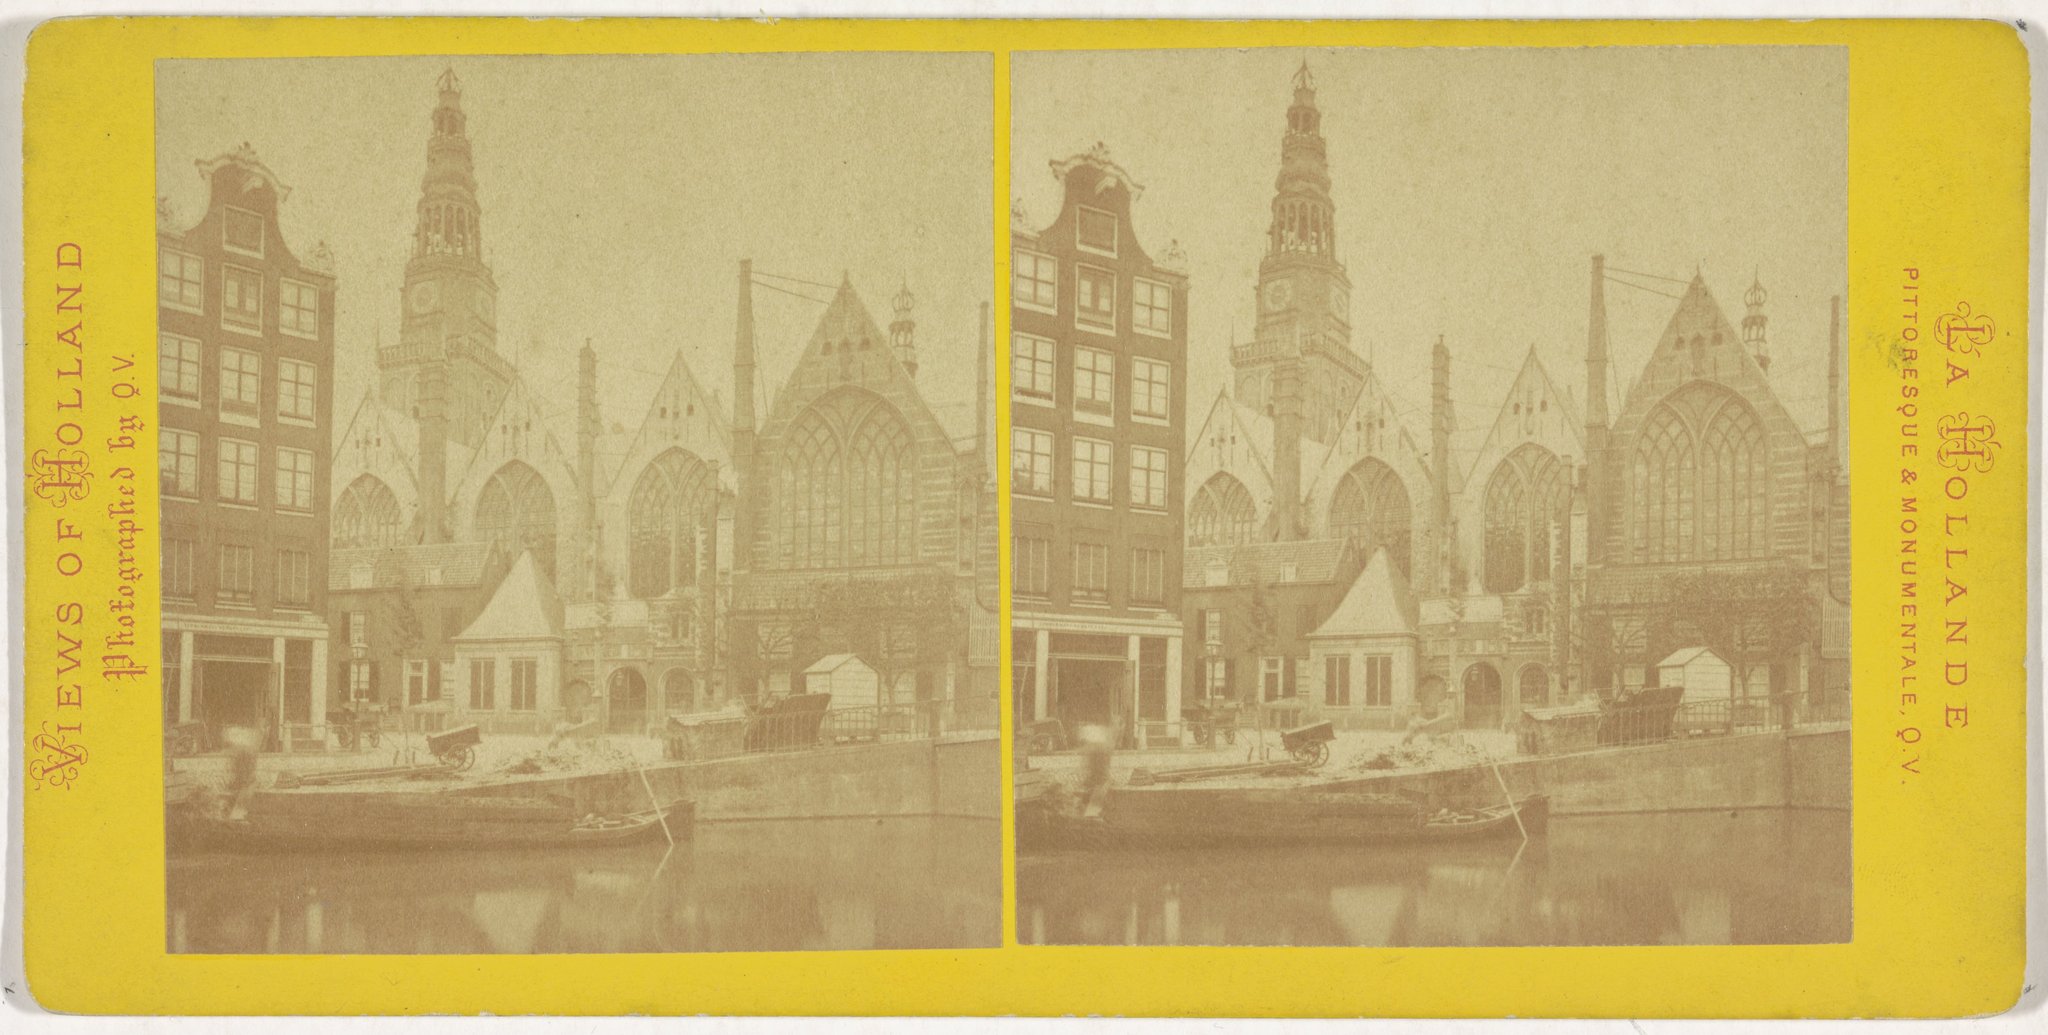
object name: stereograph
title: Gezicht op de Oude Kerk te Amsterdam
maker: jules hippolyte quéval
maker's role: publisher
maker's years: 1824-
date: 1860-1880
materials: cardboard, paper, photographic support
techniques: albumen print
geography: amsterdam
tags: oude kerk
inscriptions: label: ‘Nº 2061 Amsterdam / L'ancienne église (oude Kerk).’, title: ‘Views of Holland’, title: ‘La Hollande pittoresque & monumentale, Q.V.’